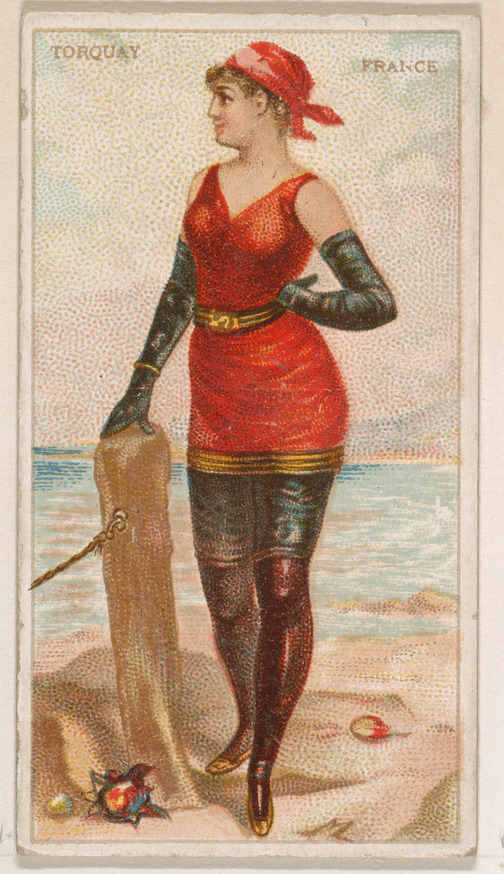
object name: print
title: Torquay, France, from the Surf Beauties series (N232), issued by Kinney Bros.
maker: kinney brothers tobacco company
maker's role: publisher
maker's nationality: american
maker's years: 1869-2011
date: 1889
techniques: color lithograph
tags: profiles,women